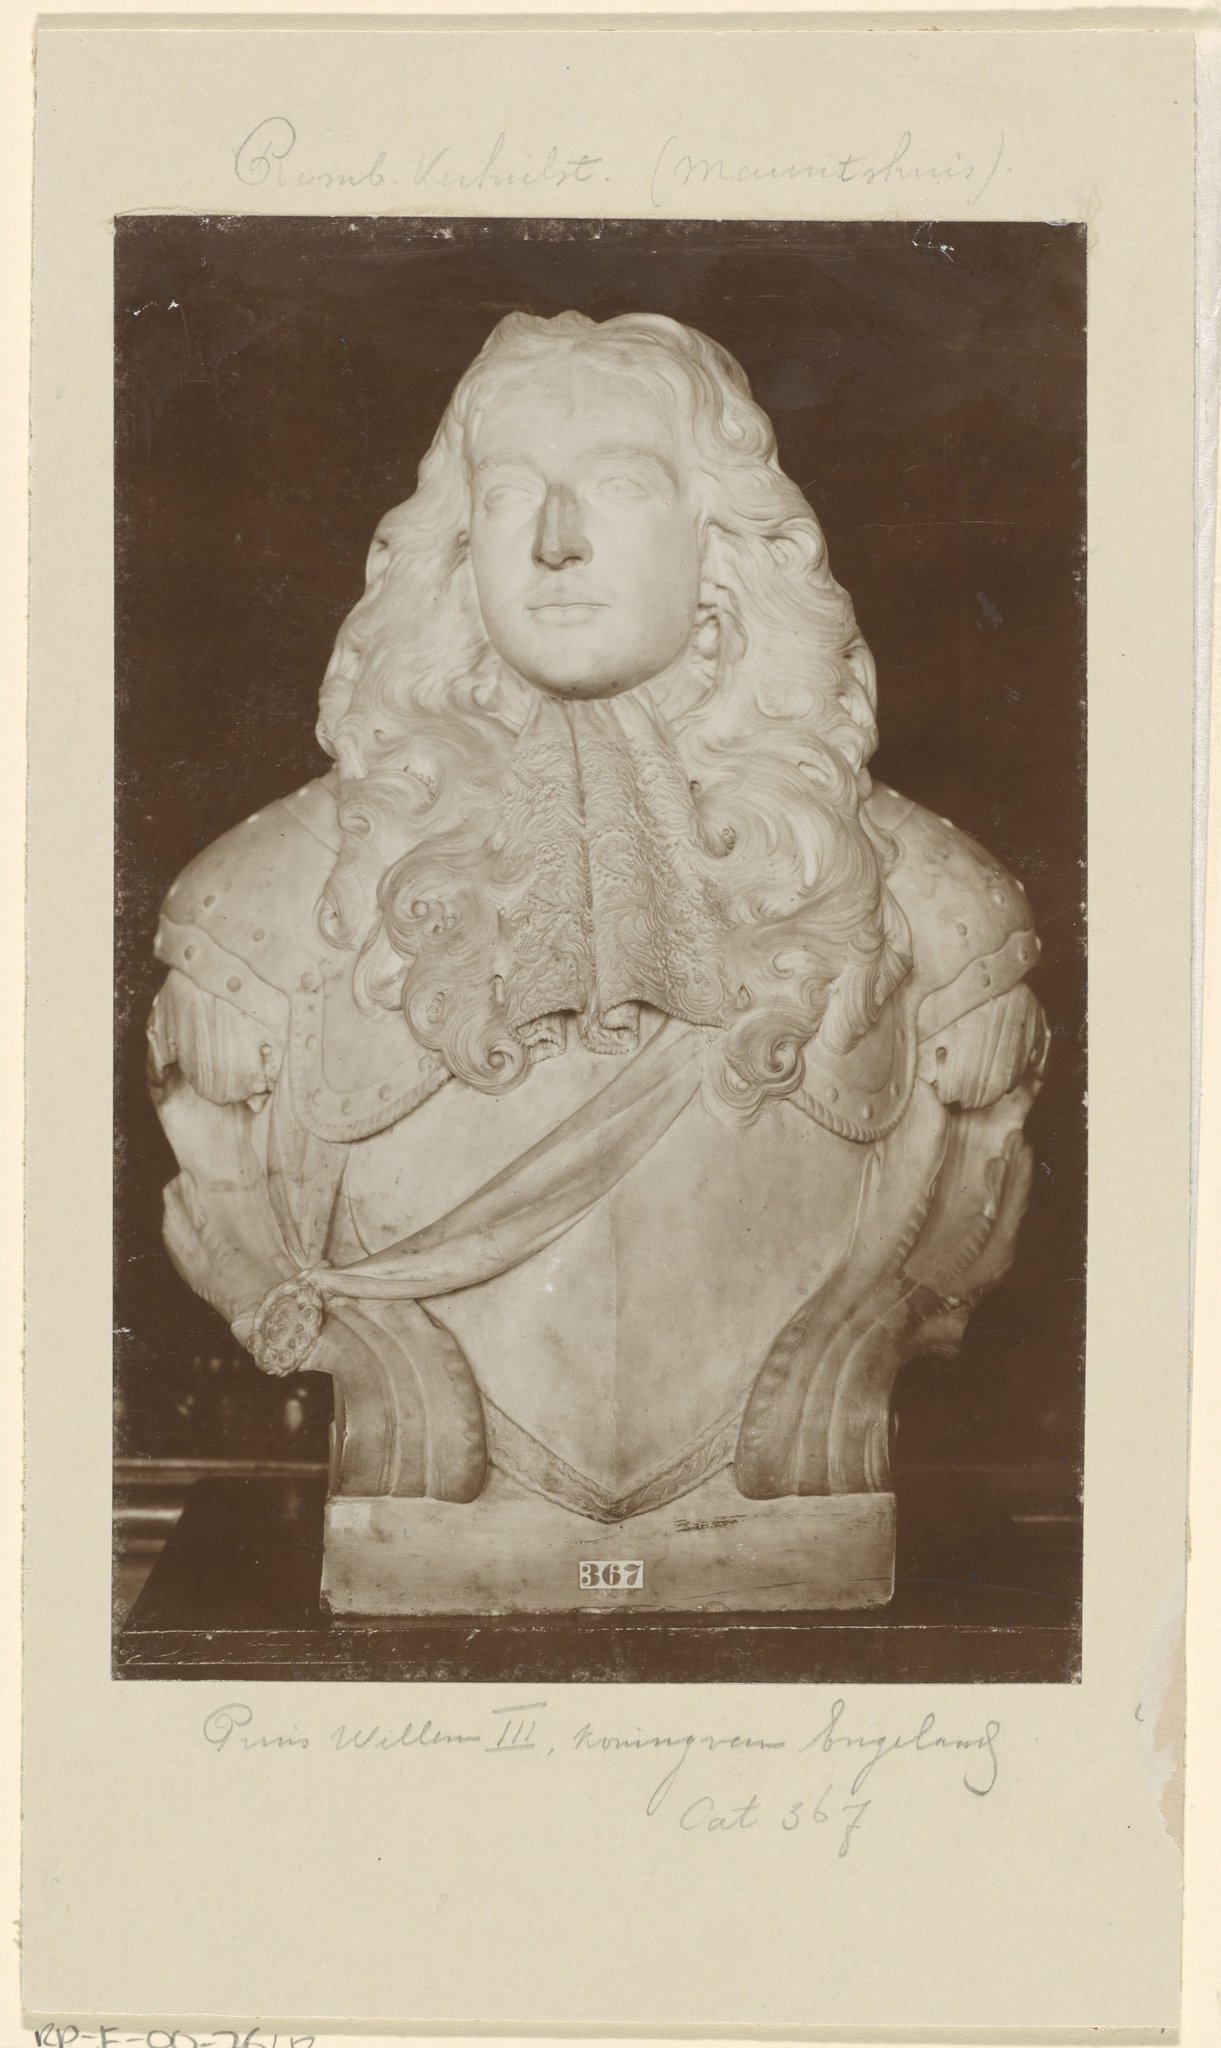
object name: photograph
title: Buste van Willem III, prins van Oranje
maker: Anonymous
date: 1850-1930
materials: photographic support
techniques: photography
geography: netherlands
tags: william iii (prince of orange and king of england, scotland, and ireland), piece of sculpture, reproduction of a piece of sculpture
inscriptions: collector's mark: Lugt 2228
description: De hier vermelde titel verwijst naar de hoogst verkregen titel van de geportretteerde, niet per se naar de titel die de geportretteerde op deze voorstelling draagt.